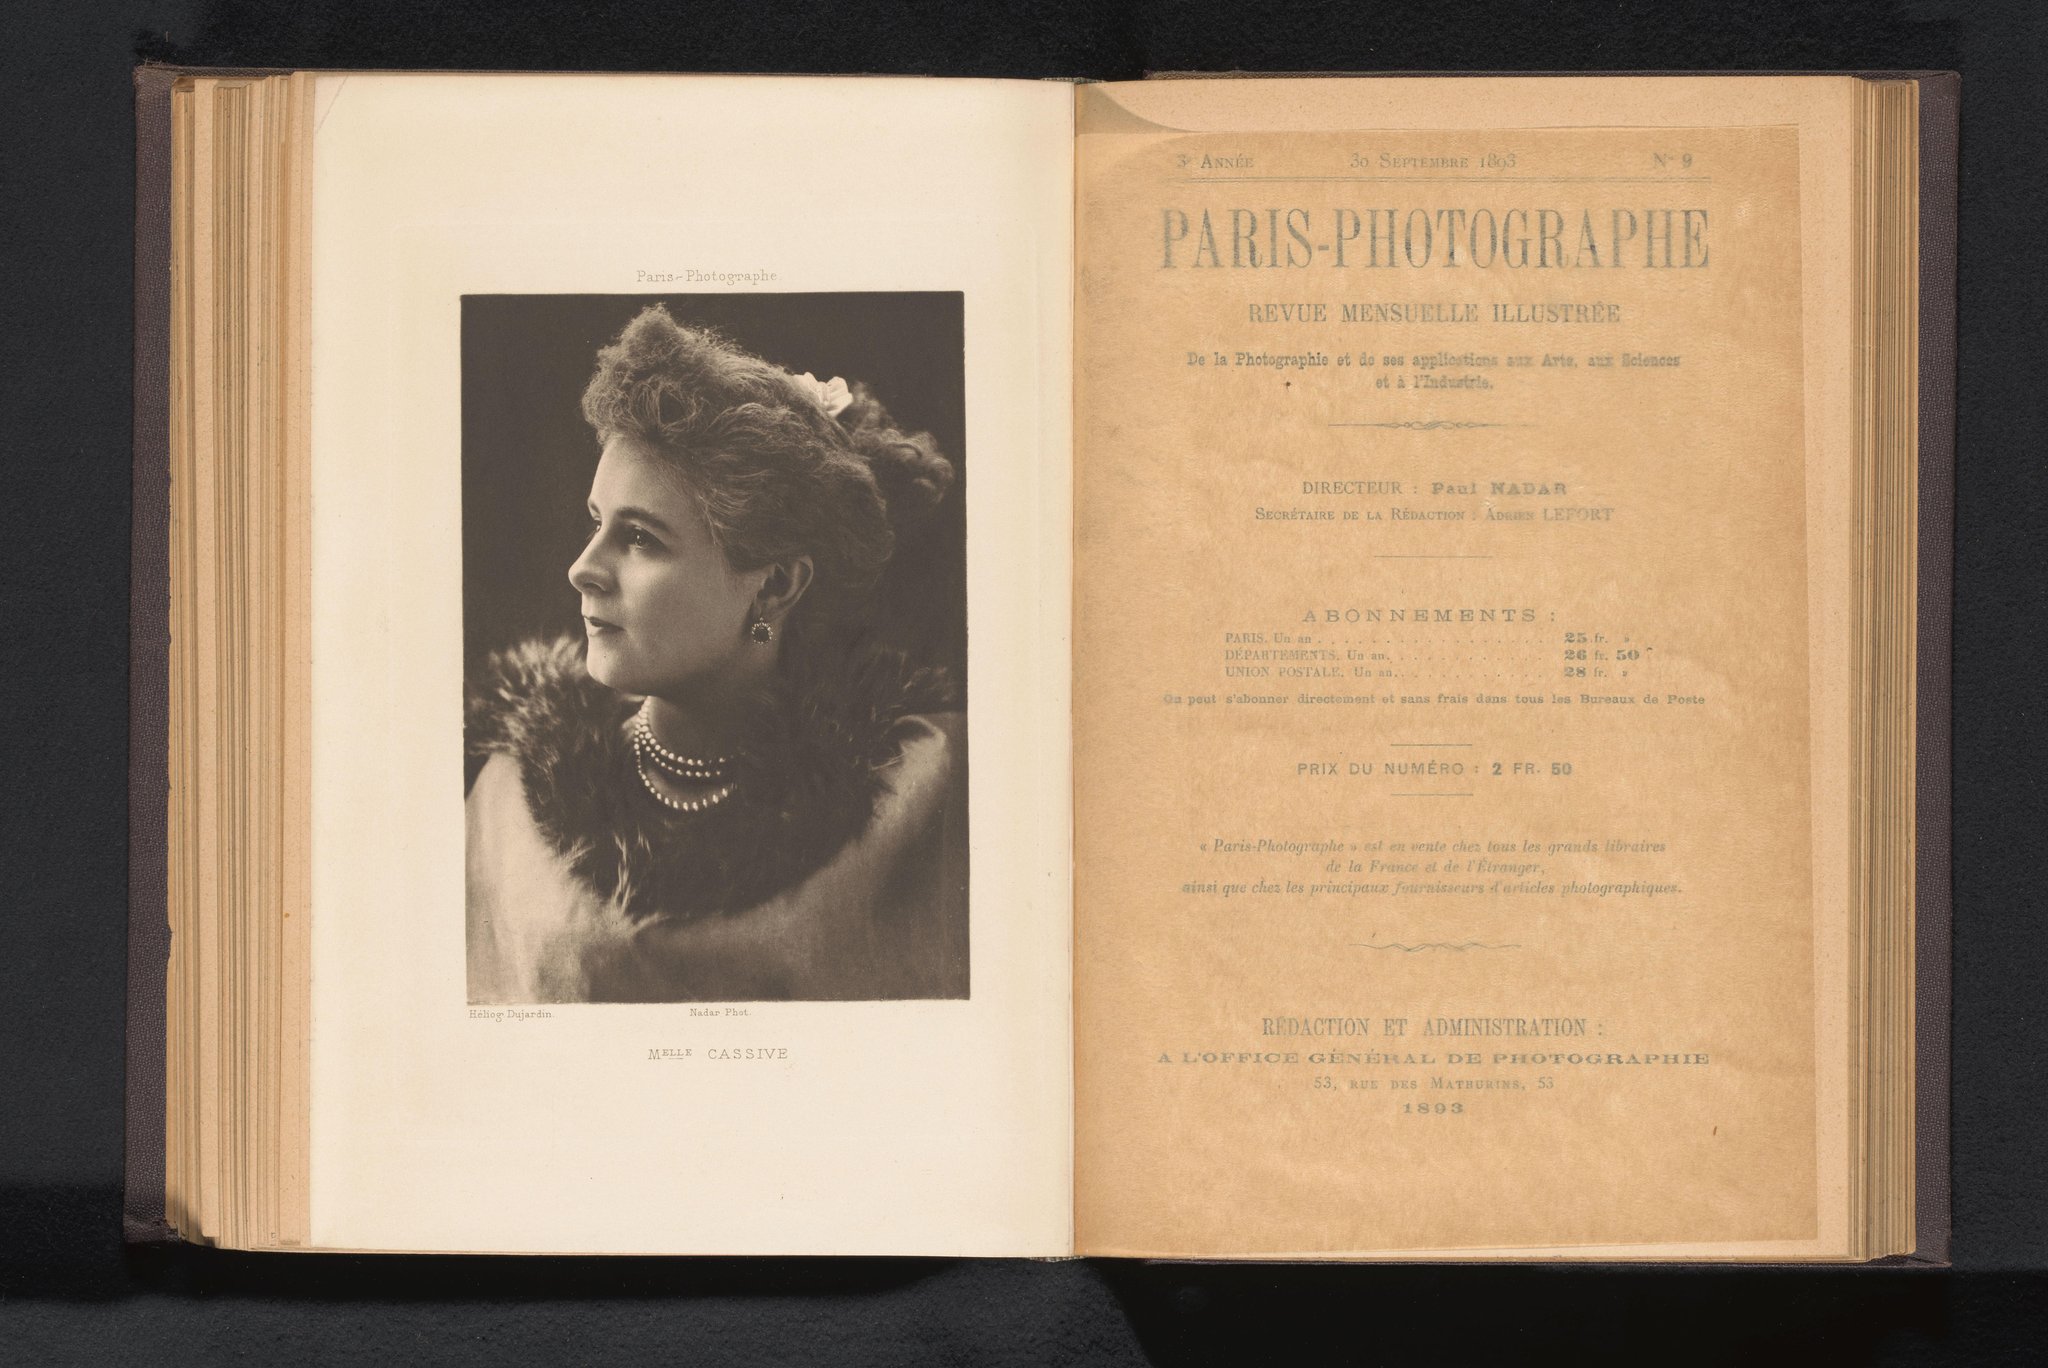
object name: photomechanical print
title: Melle Cassive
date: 1883-1893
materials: paper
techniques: photoaquatint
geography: france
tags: portrait of actor, actress